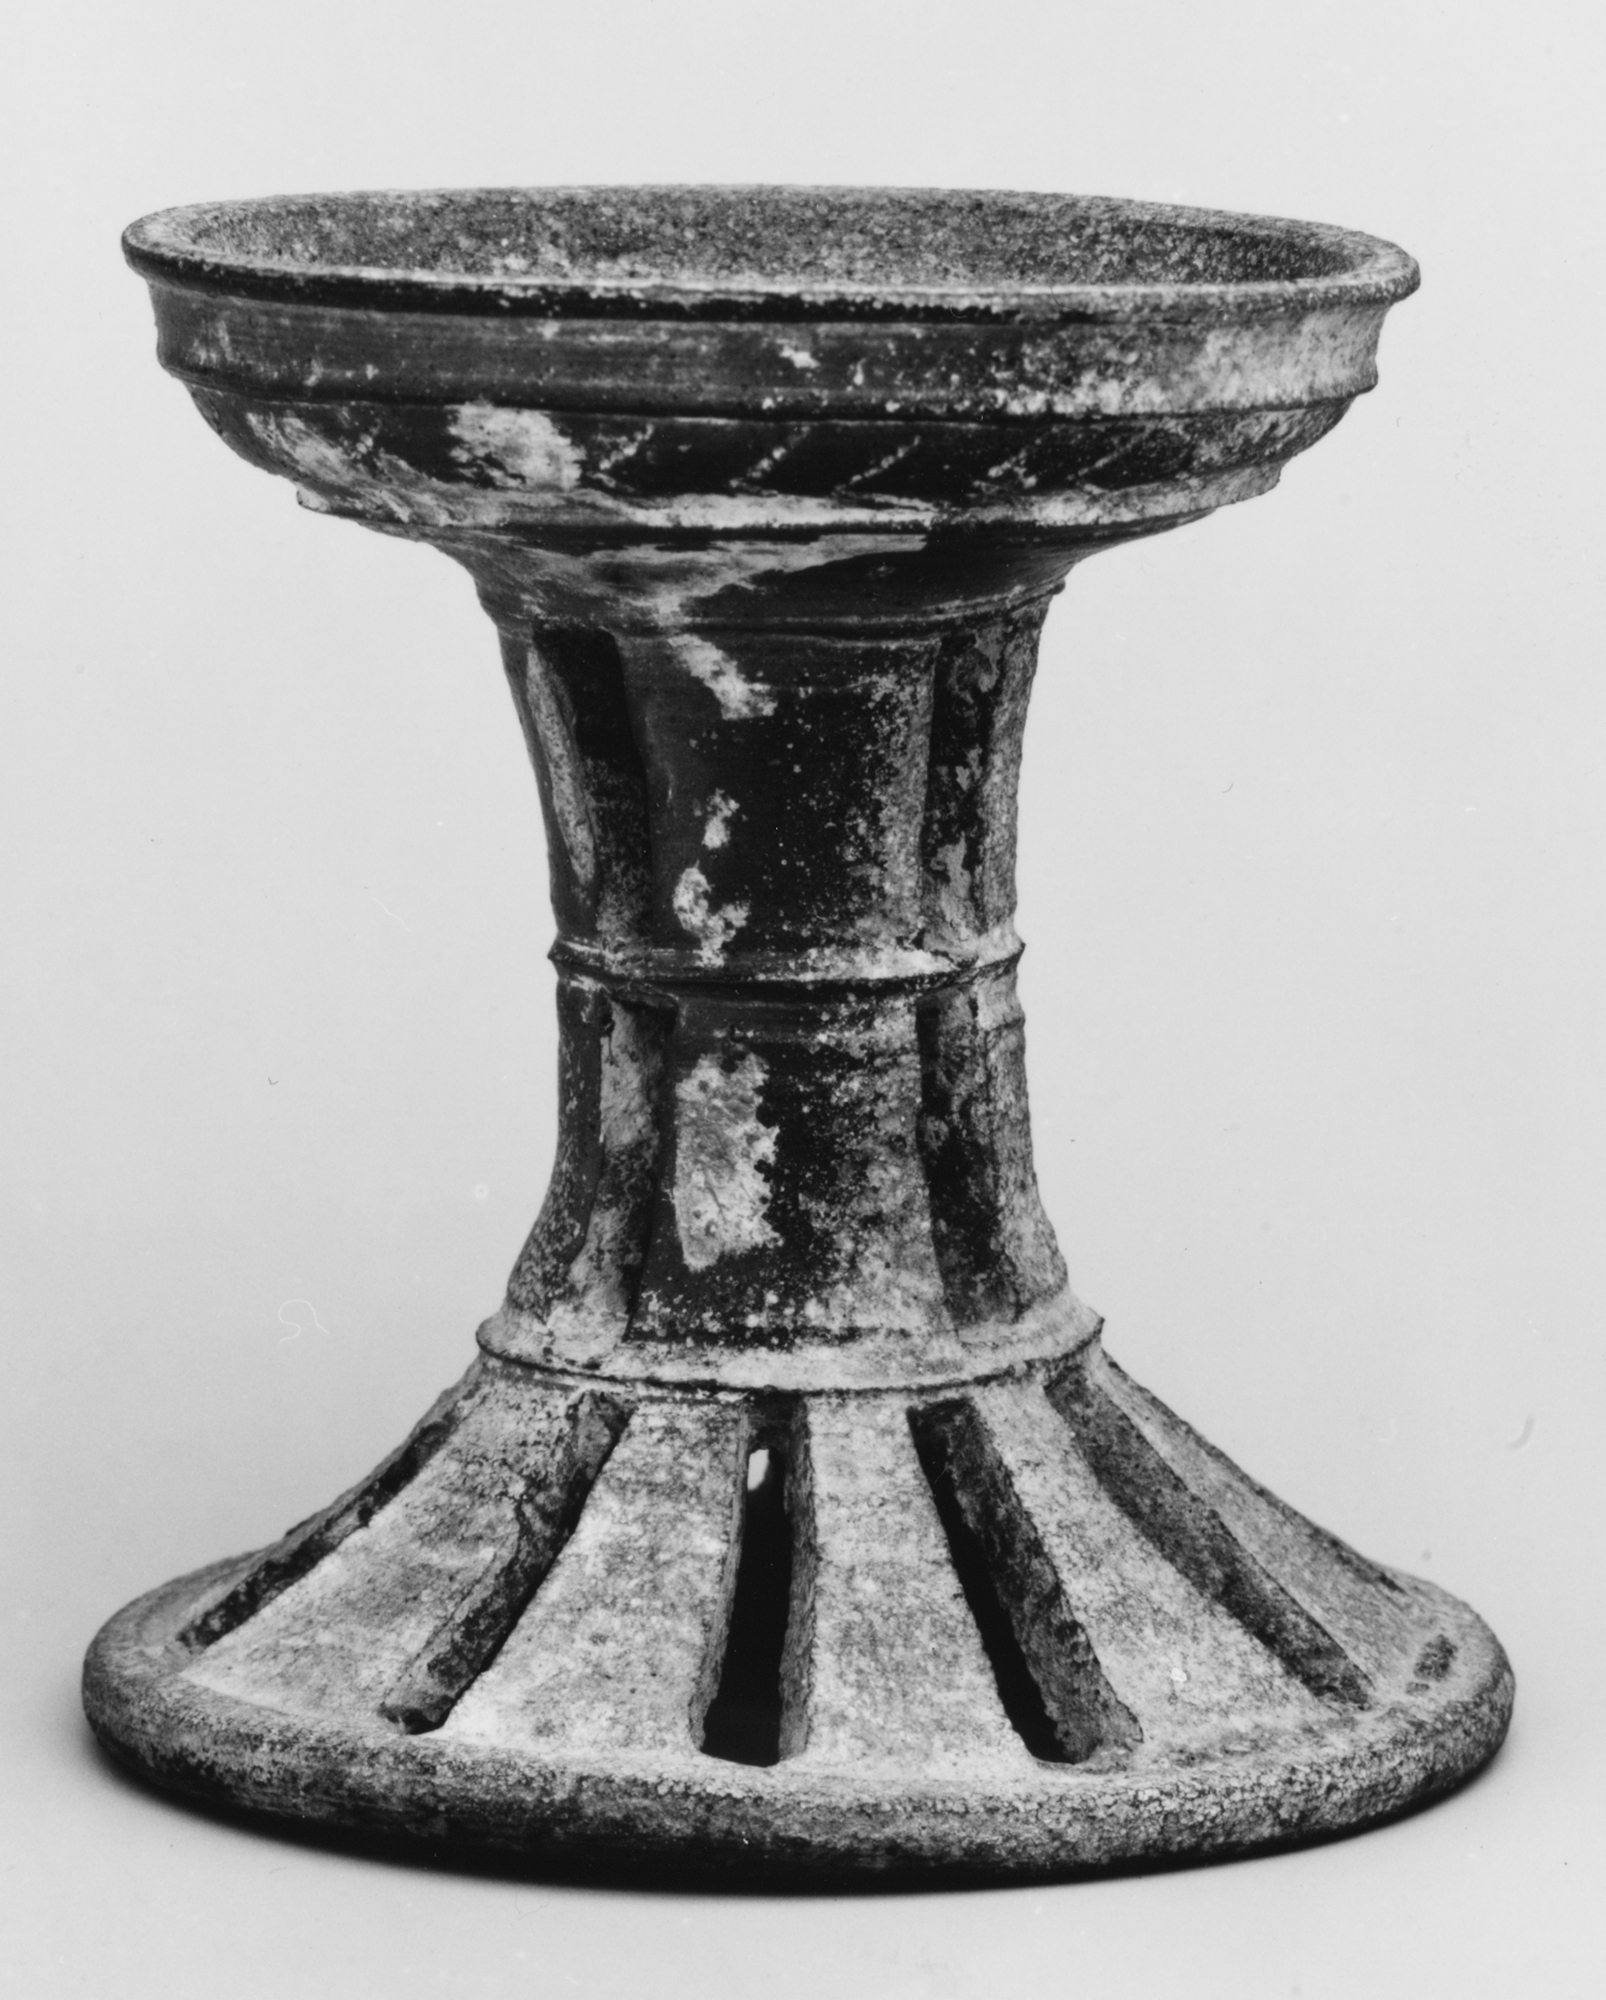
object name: pedestal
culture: korean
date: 401-600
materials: pottery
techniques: firing